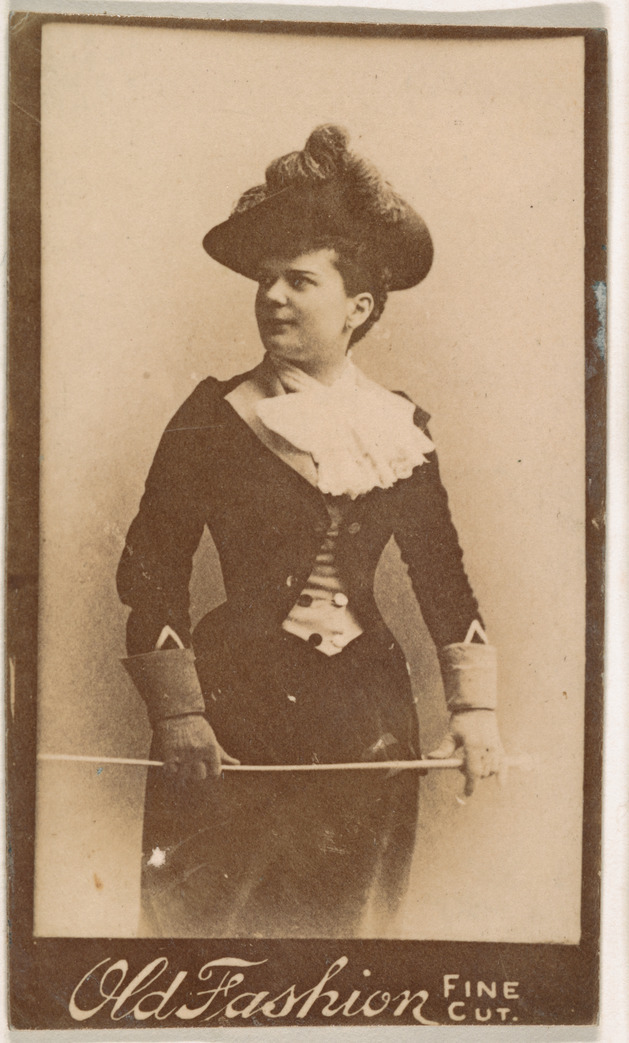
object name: photograph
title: Actress holding riding crop, from the Actresses series (N664) promoting Old Fashion Fine Cut Tobacco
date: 1888-1890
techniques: albumen silver print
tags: portraits,women,actresses